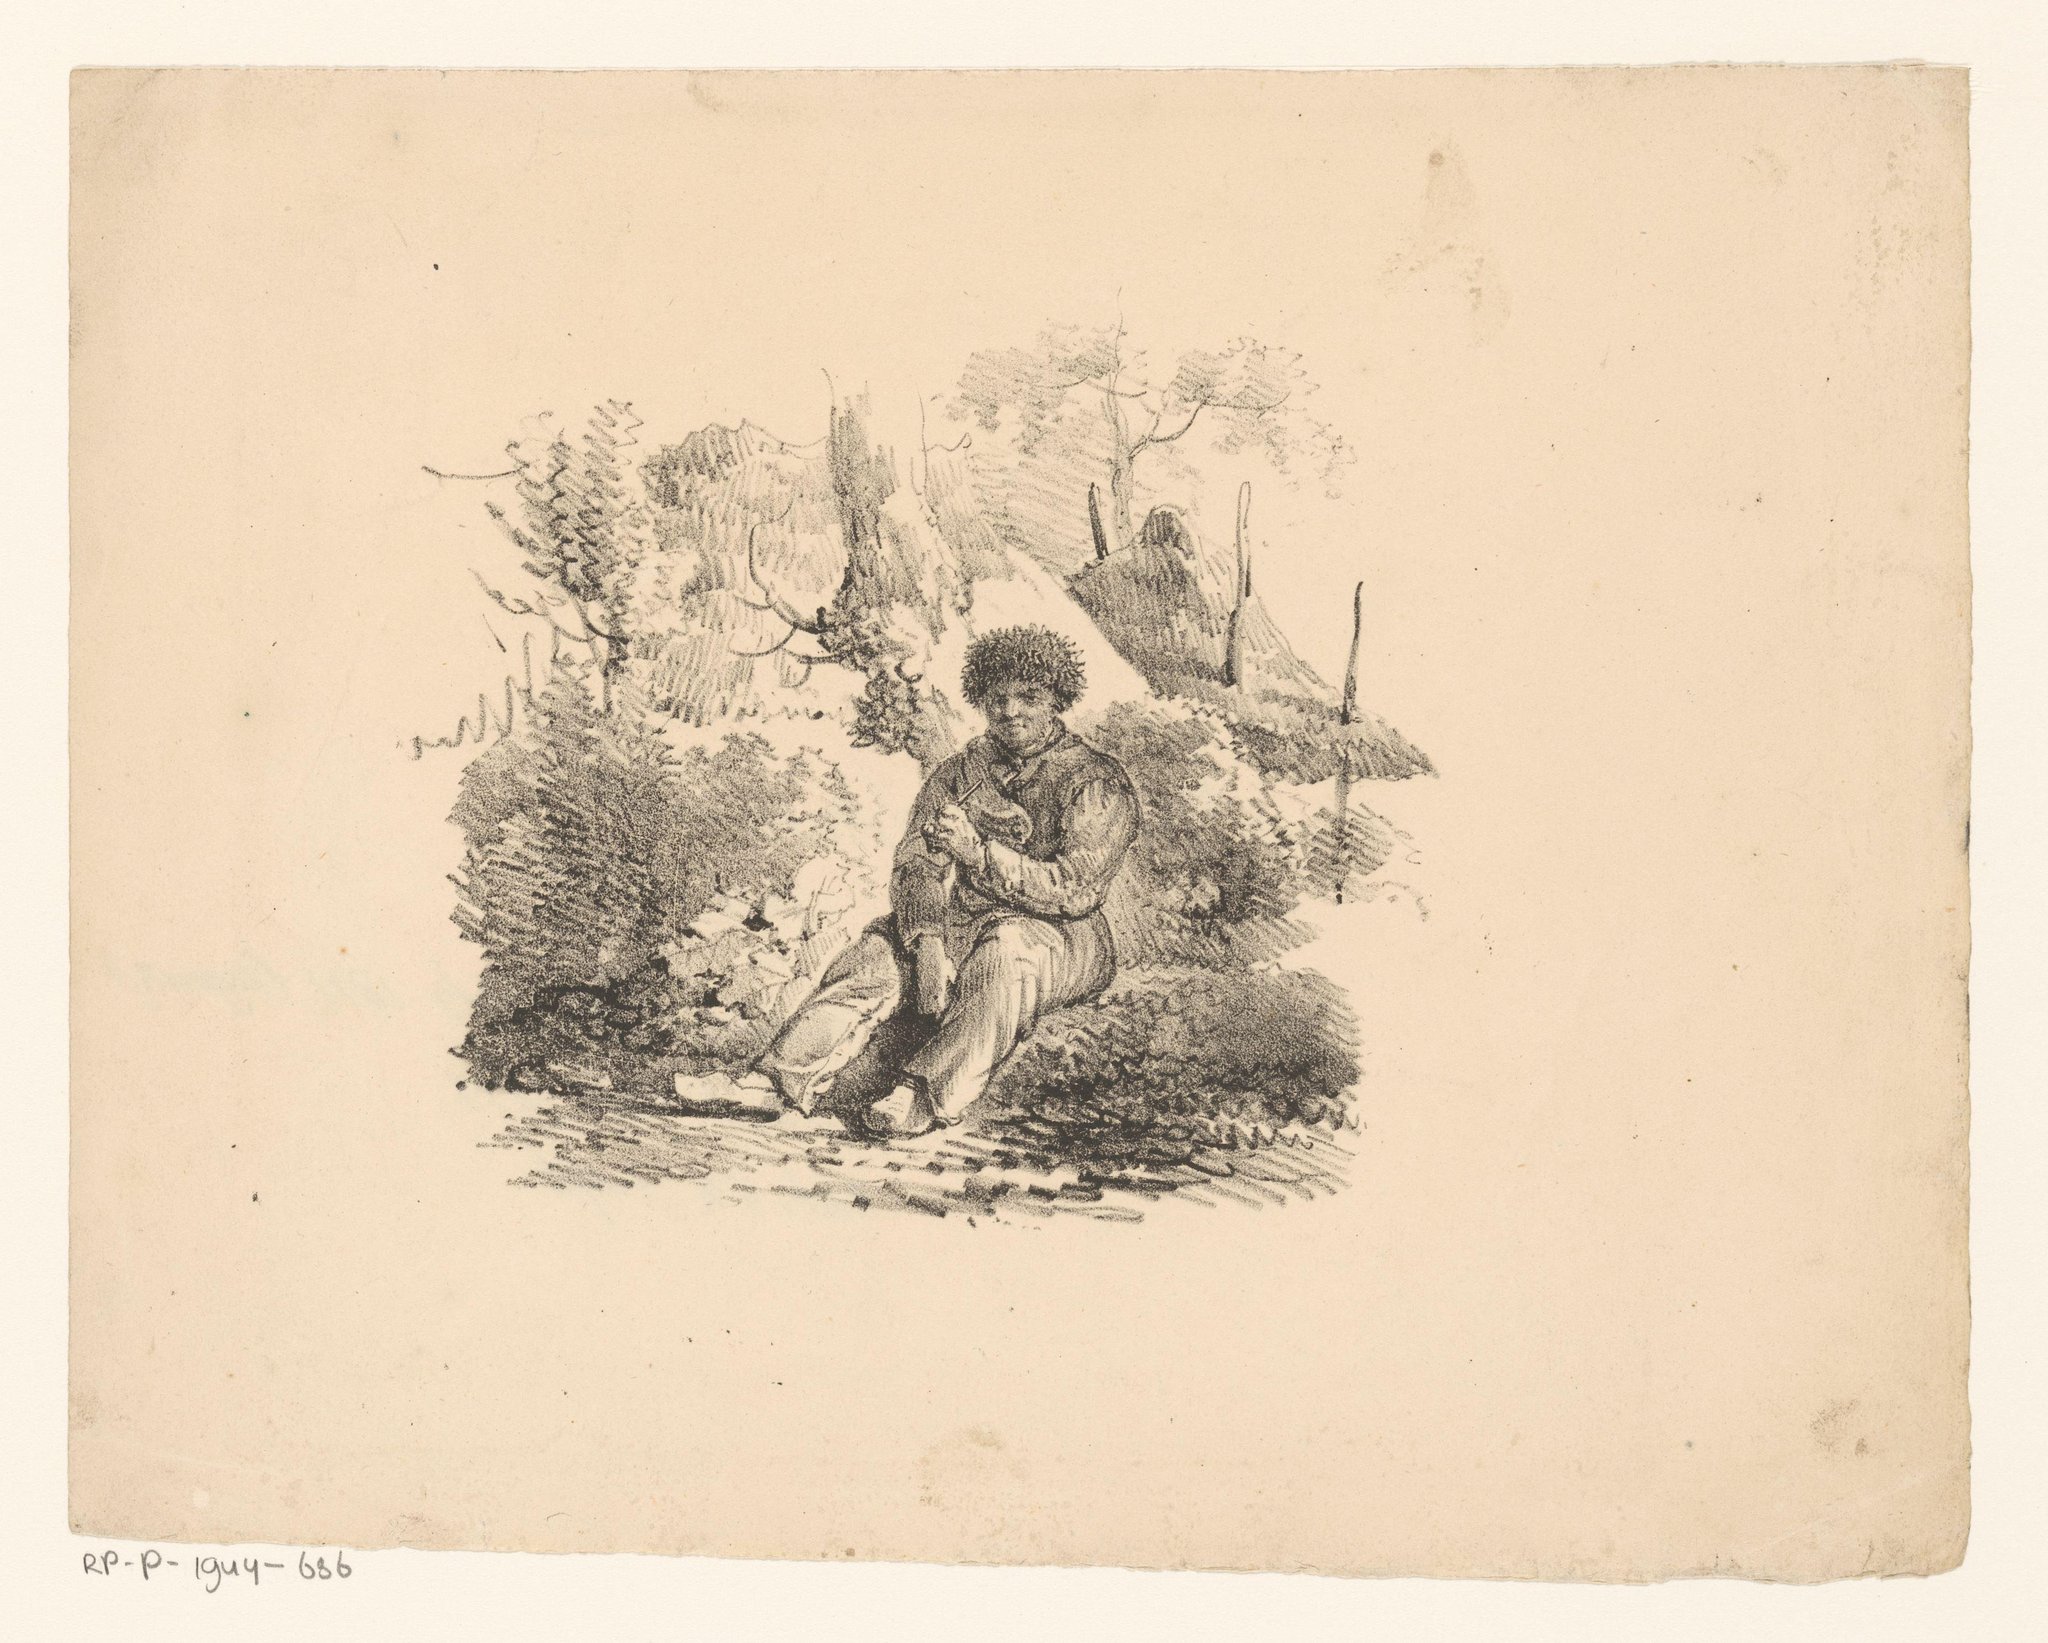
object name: print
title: Boer met pijp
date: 1811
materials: paper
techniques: lithograph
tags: pipe ~ tobacco, farmers, hay-stack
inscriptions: collector's mark: Lugt 2228, inscription: ‘Naar Marcus 1811 (...)’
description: De boer zit aan de rand van een weg. Achter hem een hooischuur.